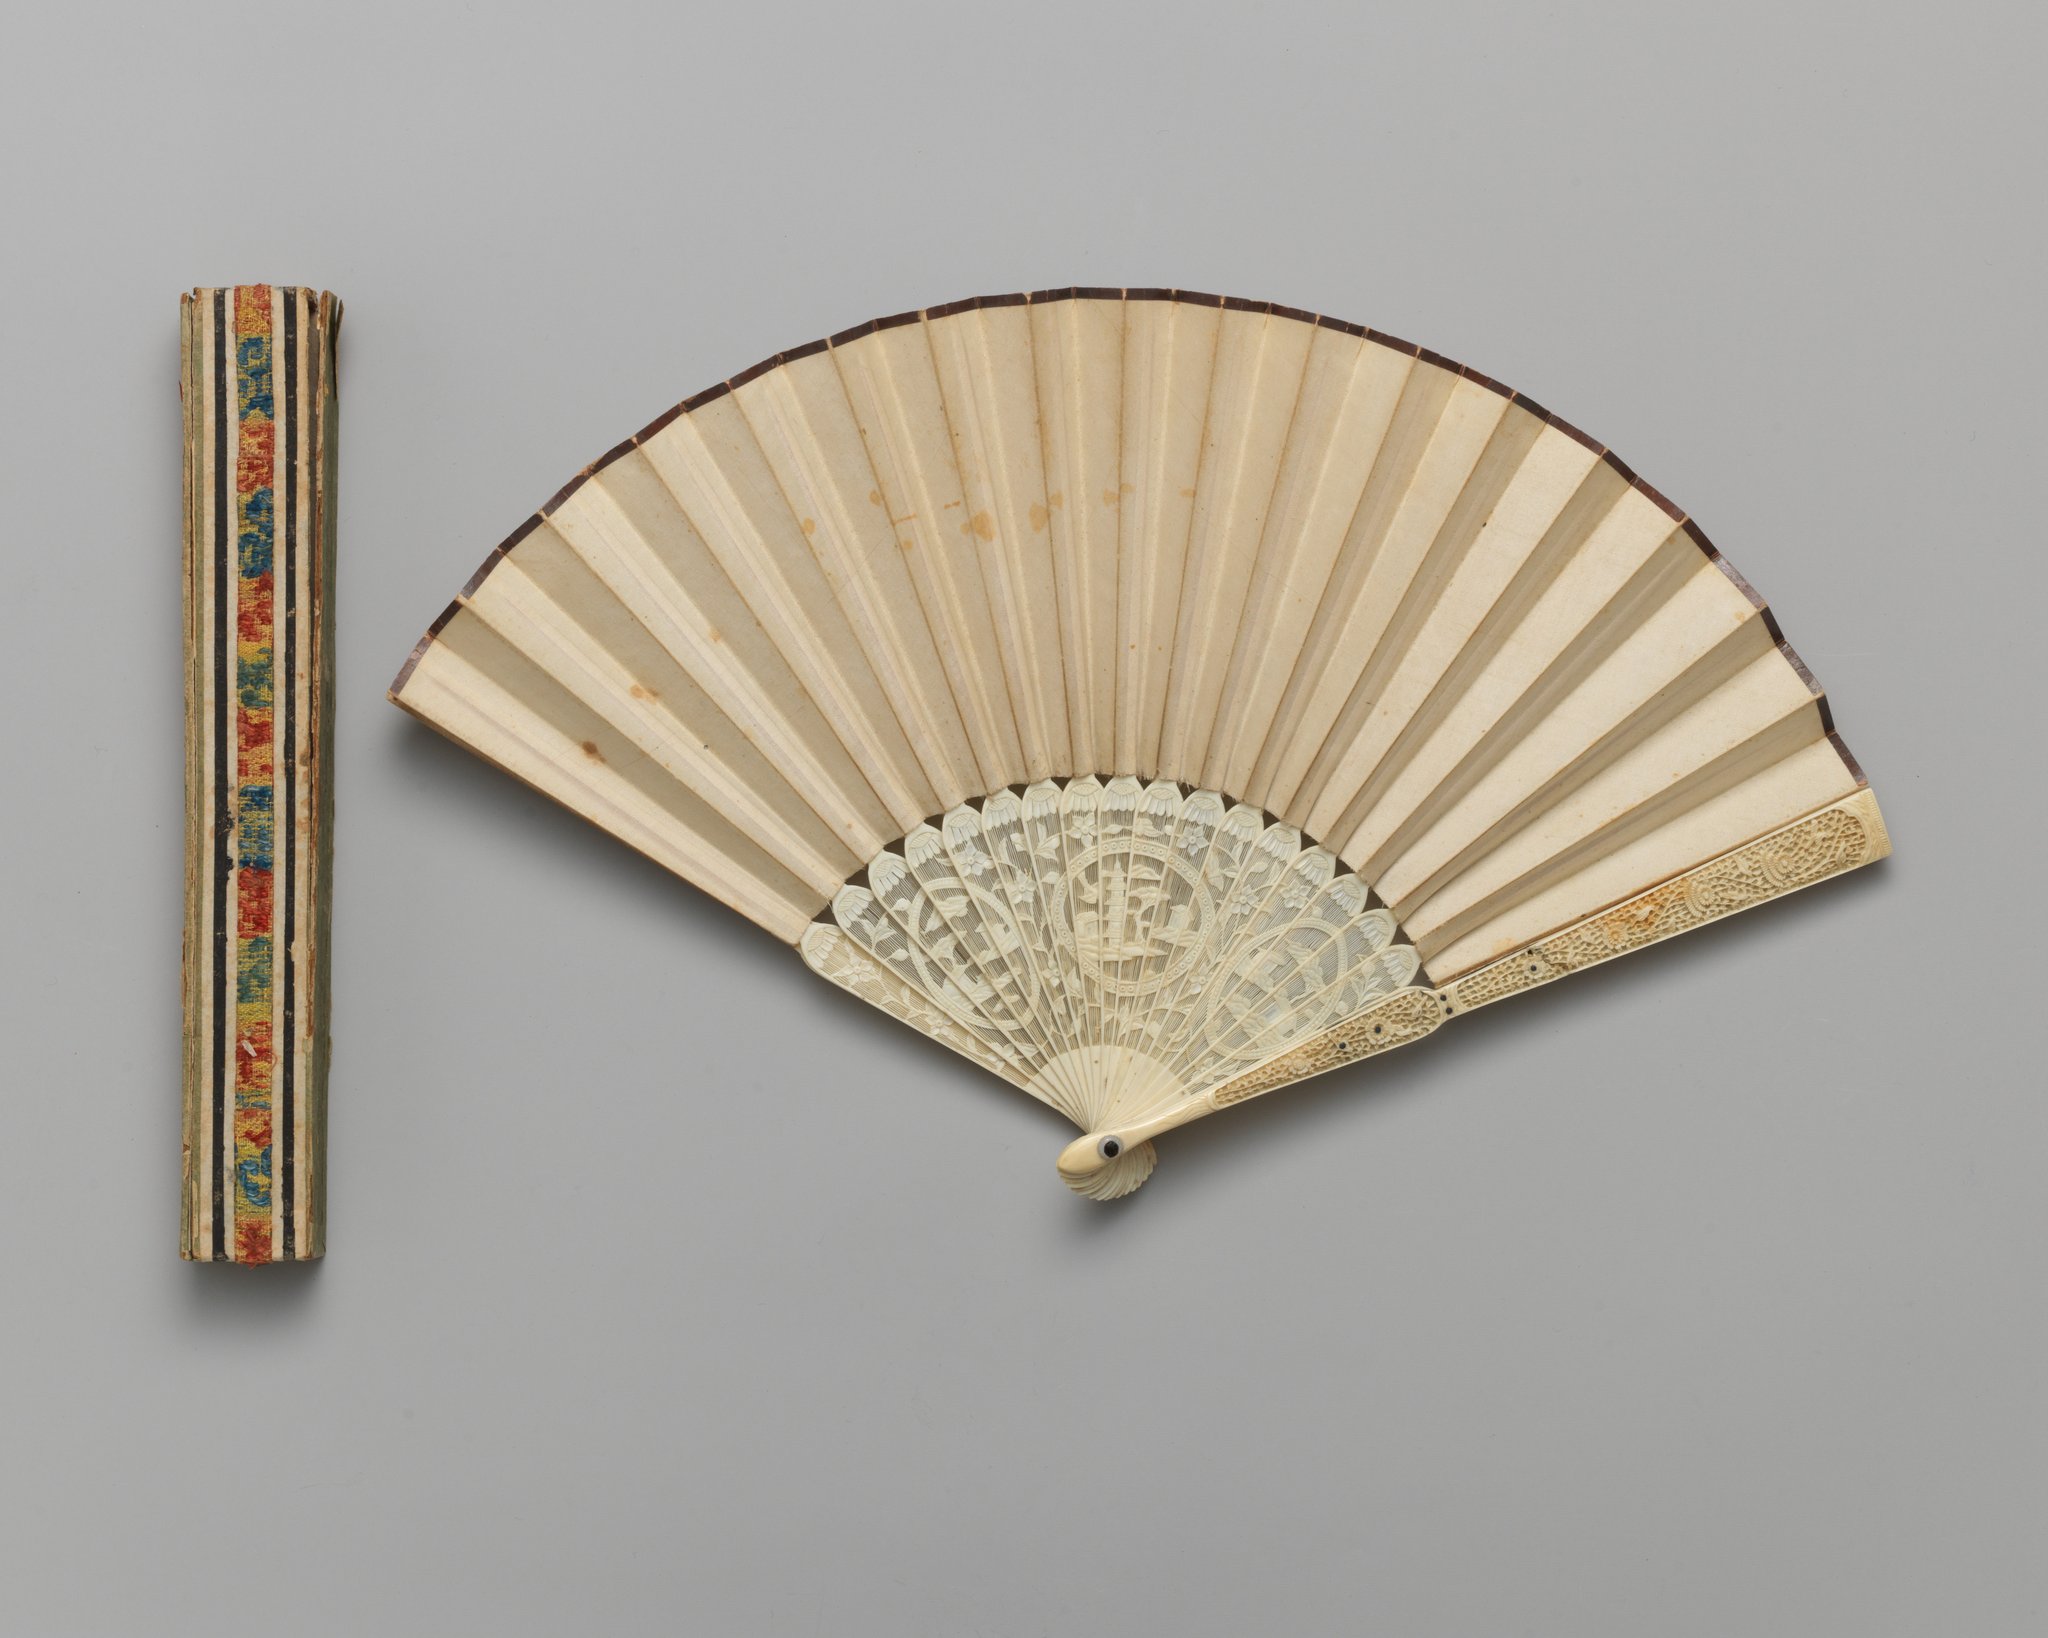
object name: fan box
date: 1801-1900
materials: cardboard